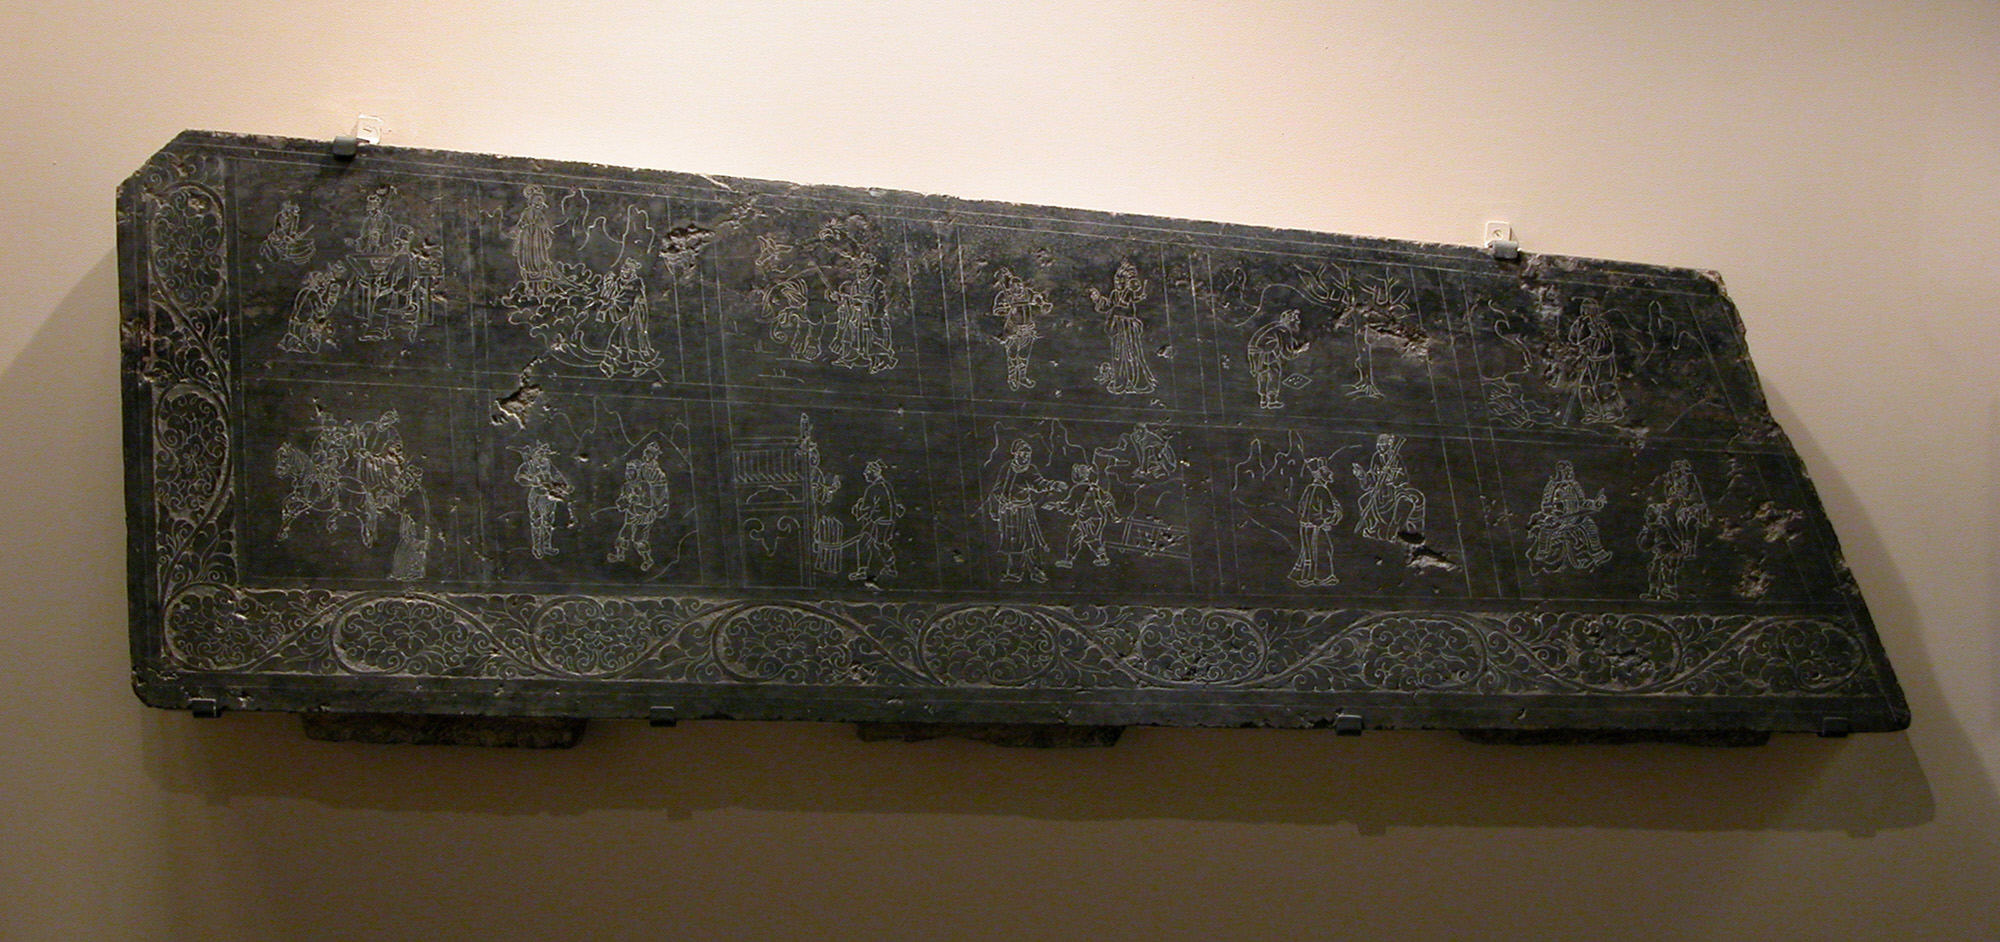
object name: sarcophagus panel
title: Side Panel from a Sarcophagus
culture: north chinese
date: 1101-1300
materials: limestone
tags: human figures,elephants